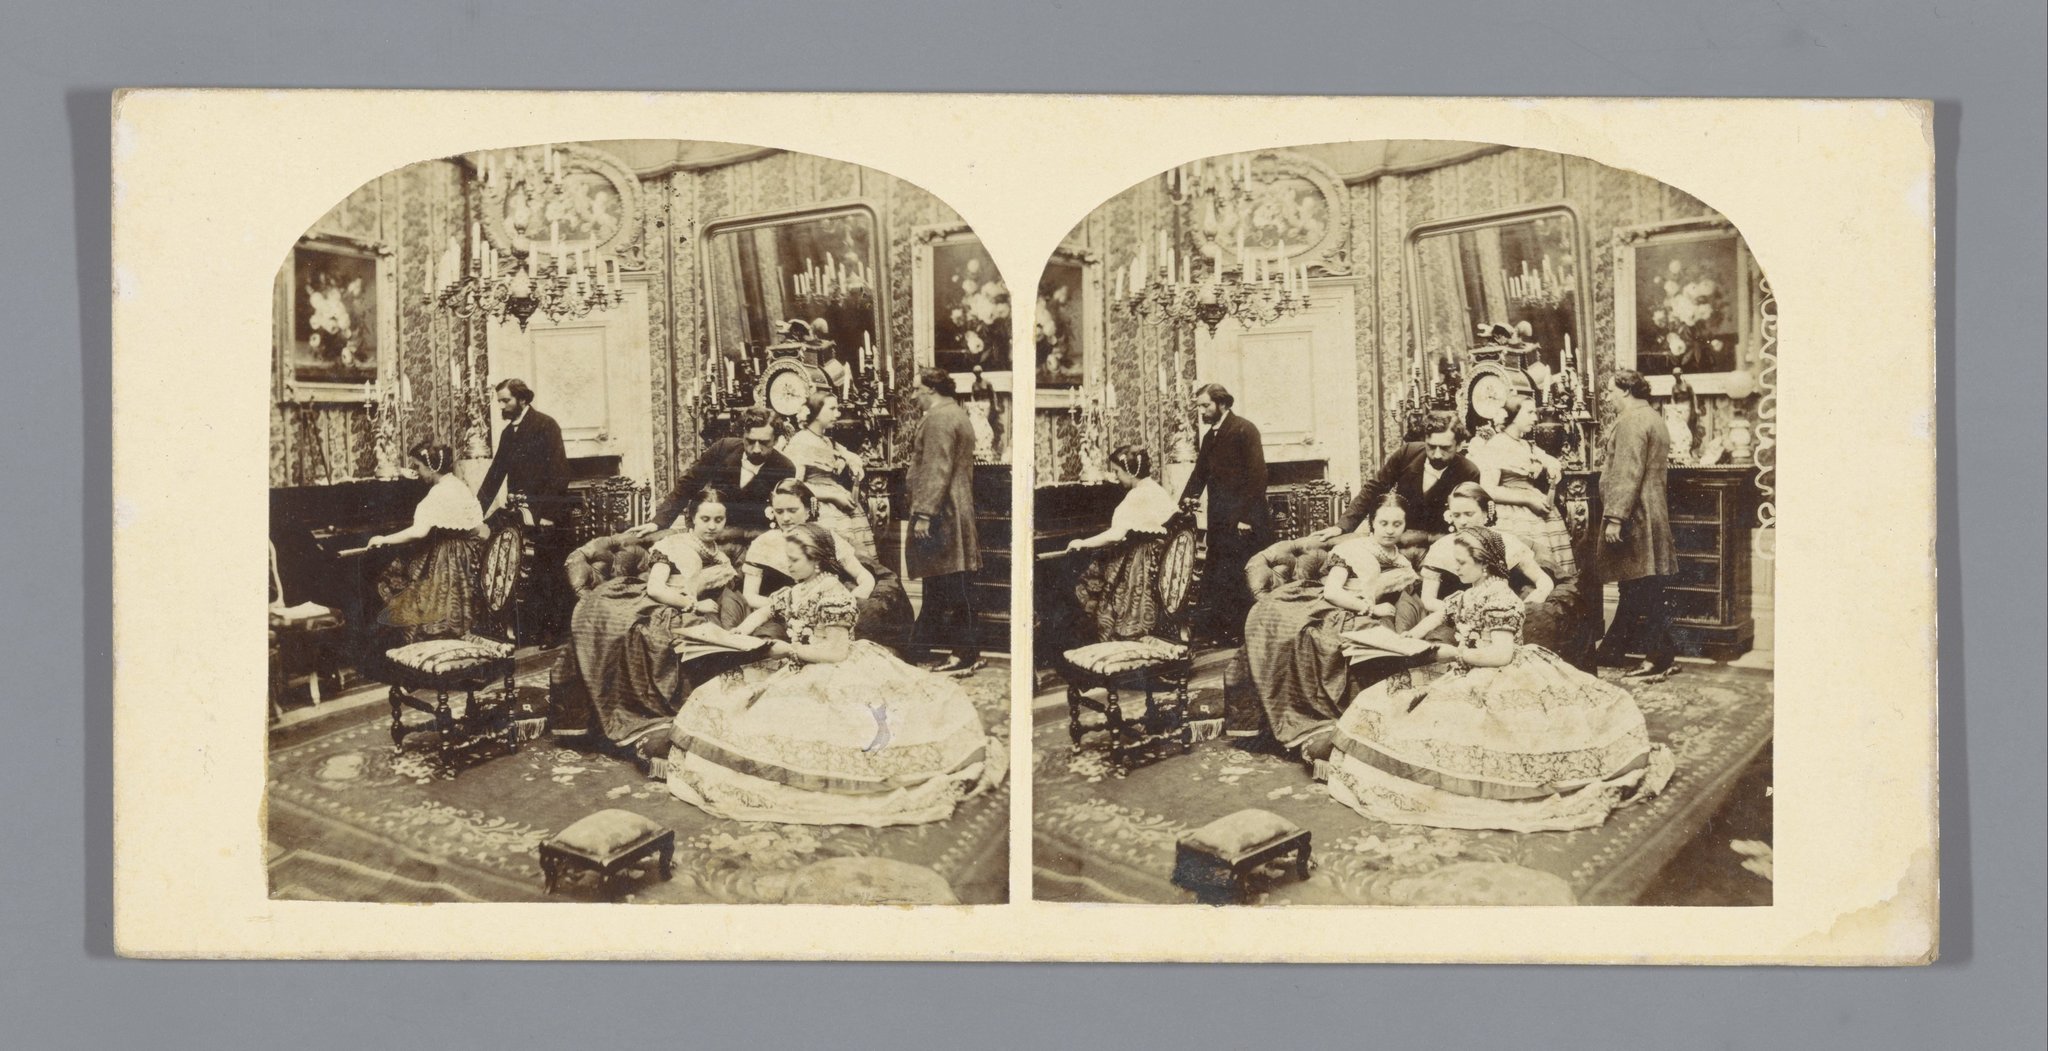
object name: stereograph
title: Gezelschap in een kamer met een piano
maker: Anonymous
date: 1850-1880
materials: cardboard, photographic support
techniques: albumen print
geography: europe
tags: grand piano, living-room, parlour, sitting-room, europe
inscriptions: number: ‘14.’, inscription